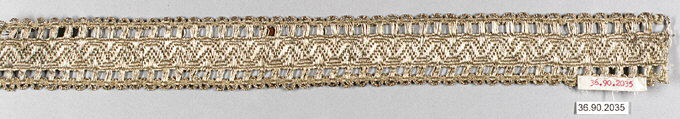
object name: galloon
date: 1801-1900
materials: metal thread